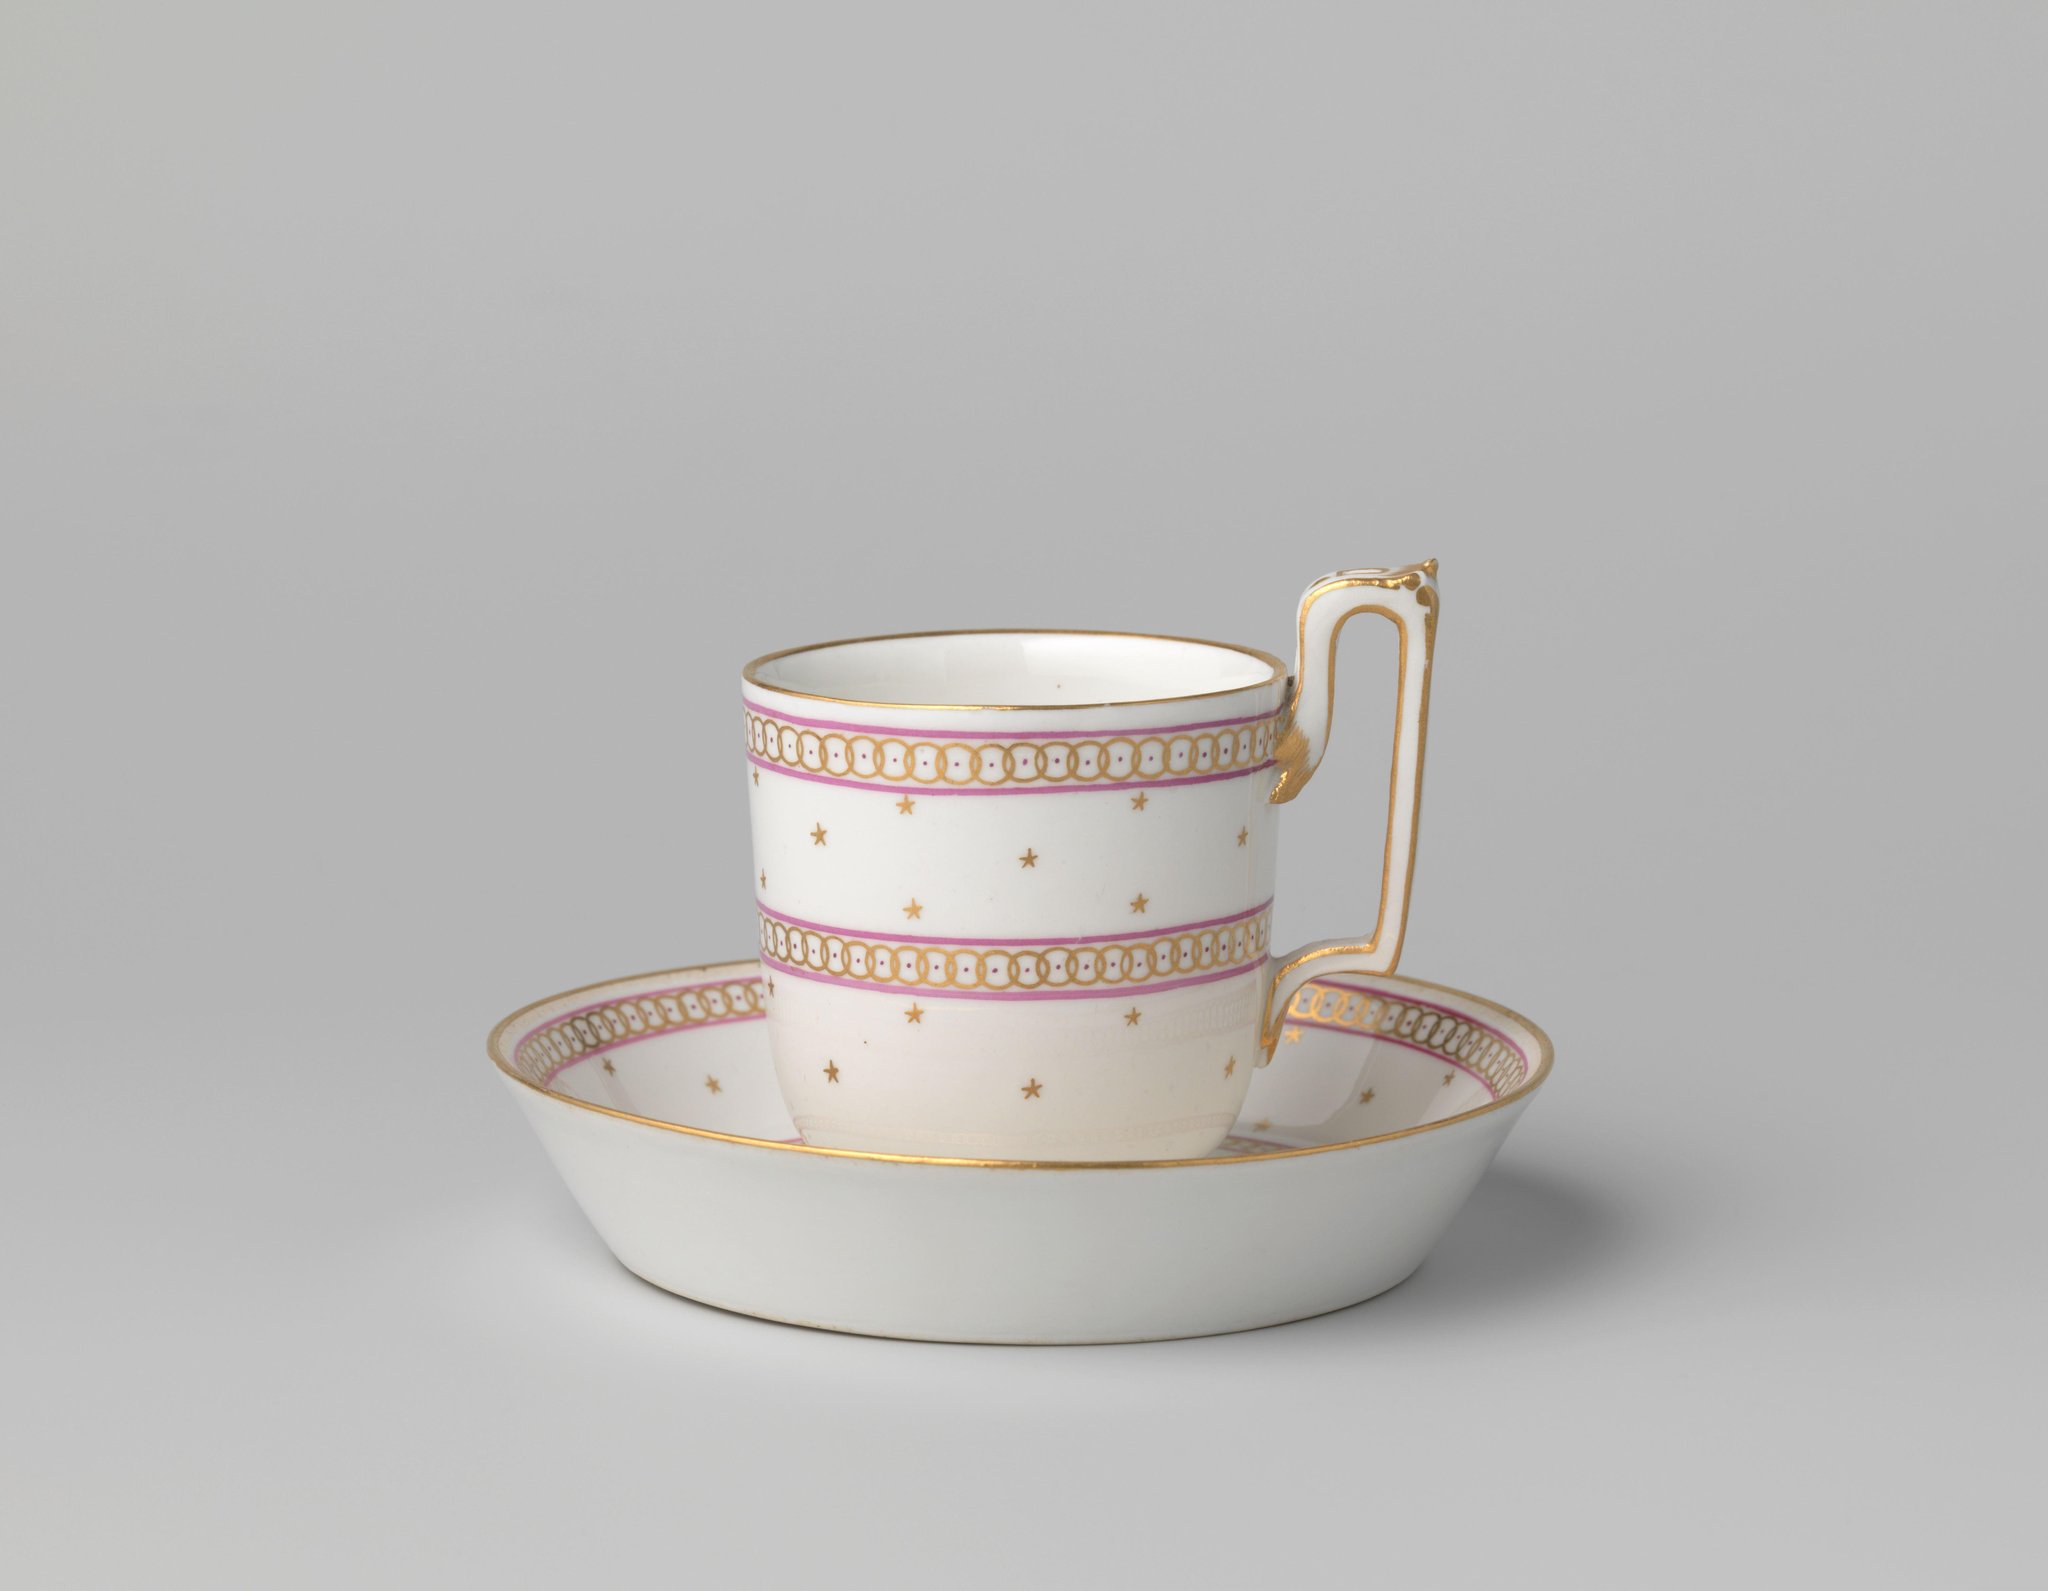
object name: kop en schotel, kop en schotel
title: Cup with stars and ornamental borders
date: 1791-1801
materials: glaze, gold, paint, porcelain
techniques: firing, forming, gilding, turning, vitrification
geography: vienna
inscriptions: mark: ‘schild/ 101/ 33/ 91’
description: Delen van een cilindervormig koffieservies bestaande uit een kan (A) en 6 koppen en schotels (B t/m G) beschilderd in paars en goud met sterretjes en kettingen. Gemerkt met een fabrieksmerk in onderglazuurblauw en ingegrift 801 26 (kan), 791 33 (koppen) 791 39 (schotels).